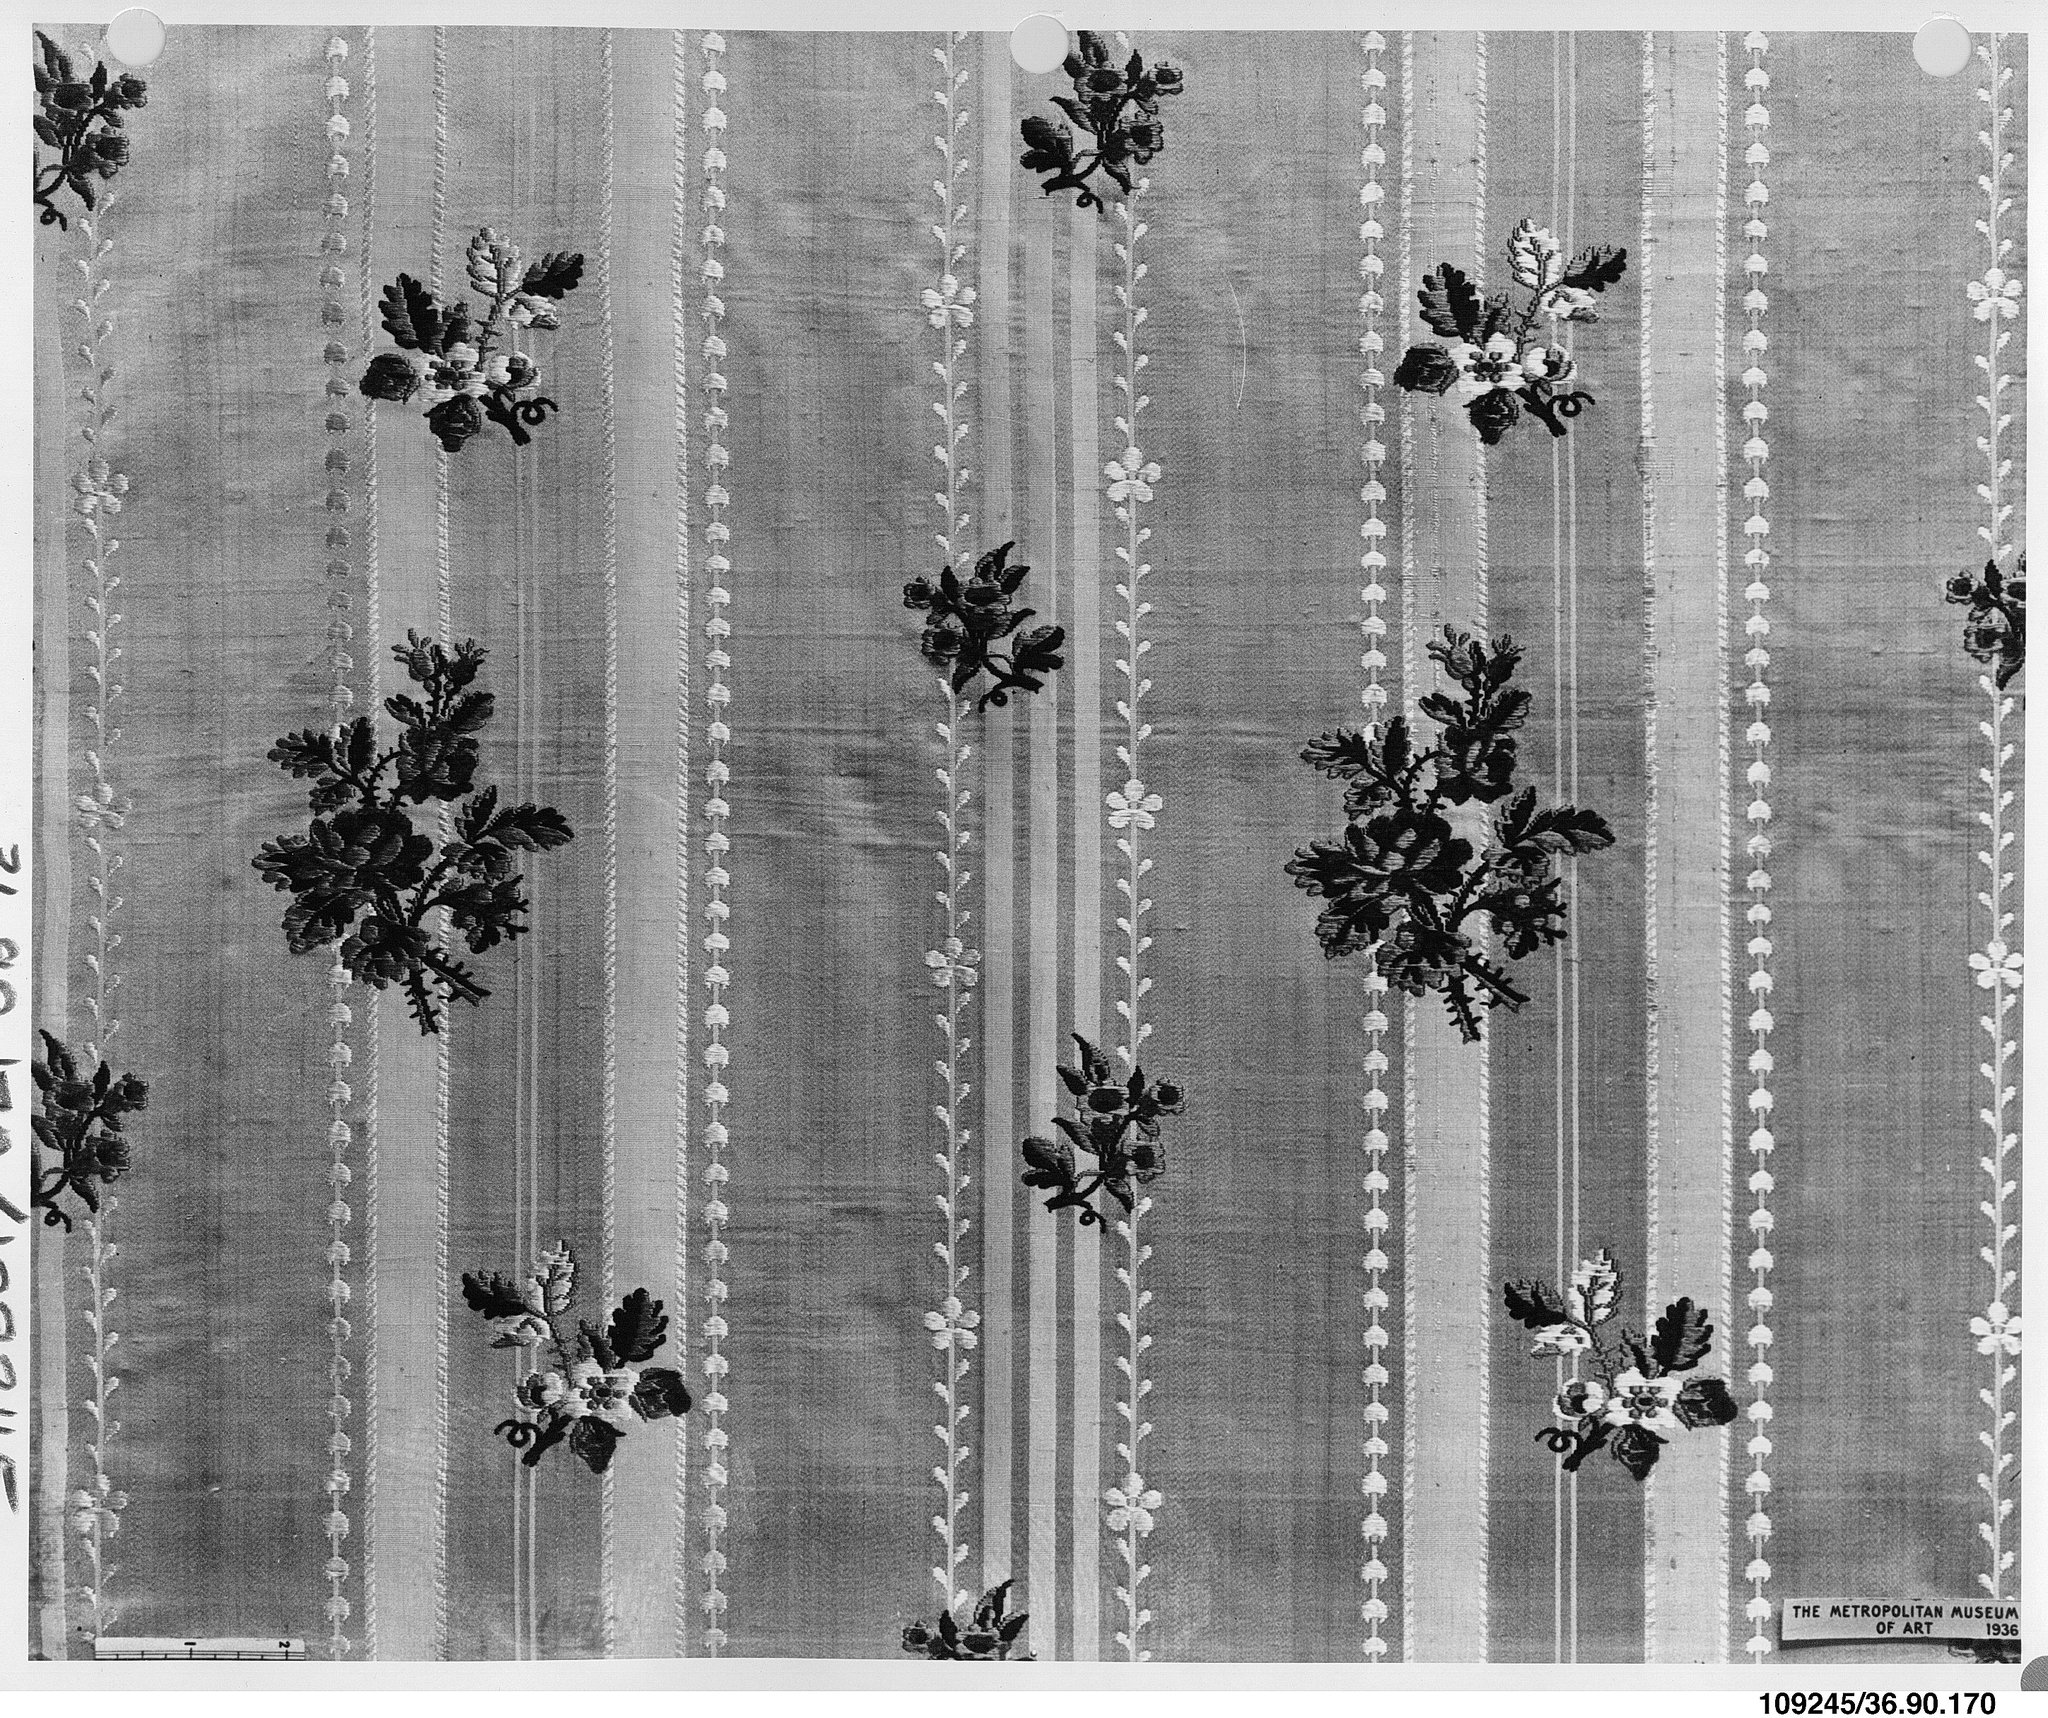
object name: piece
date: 1780-1790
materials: silk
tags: flowers,leaves